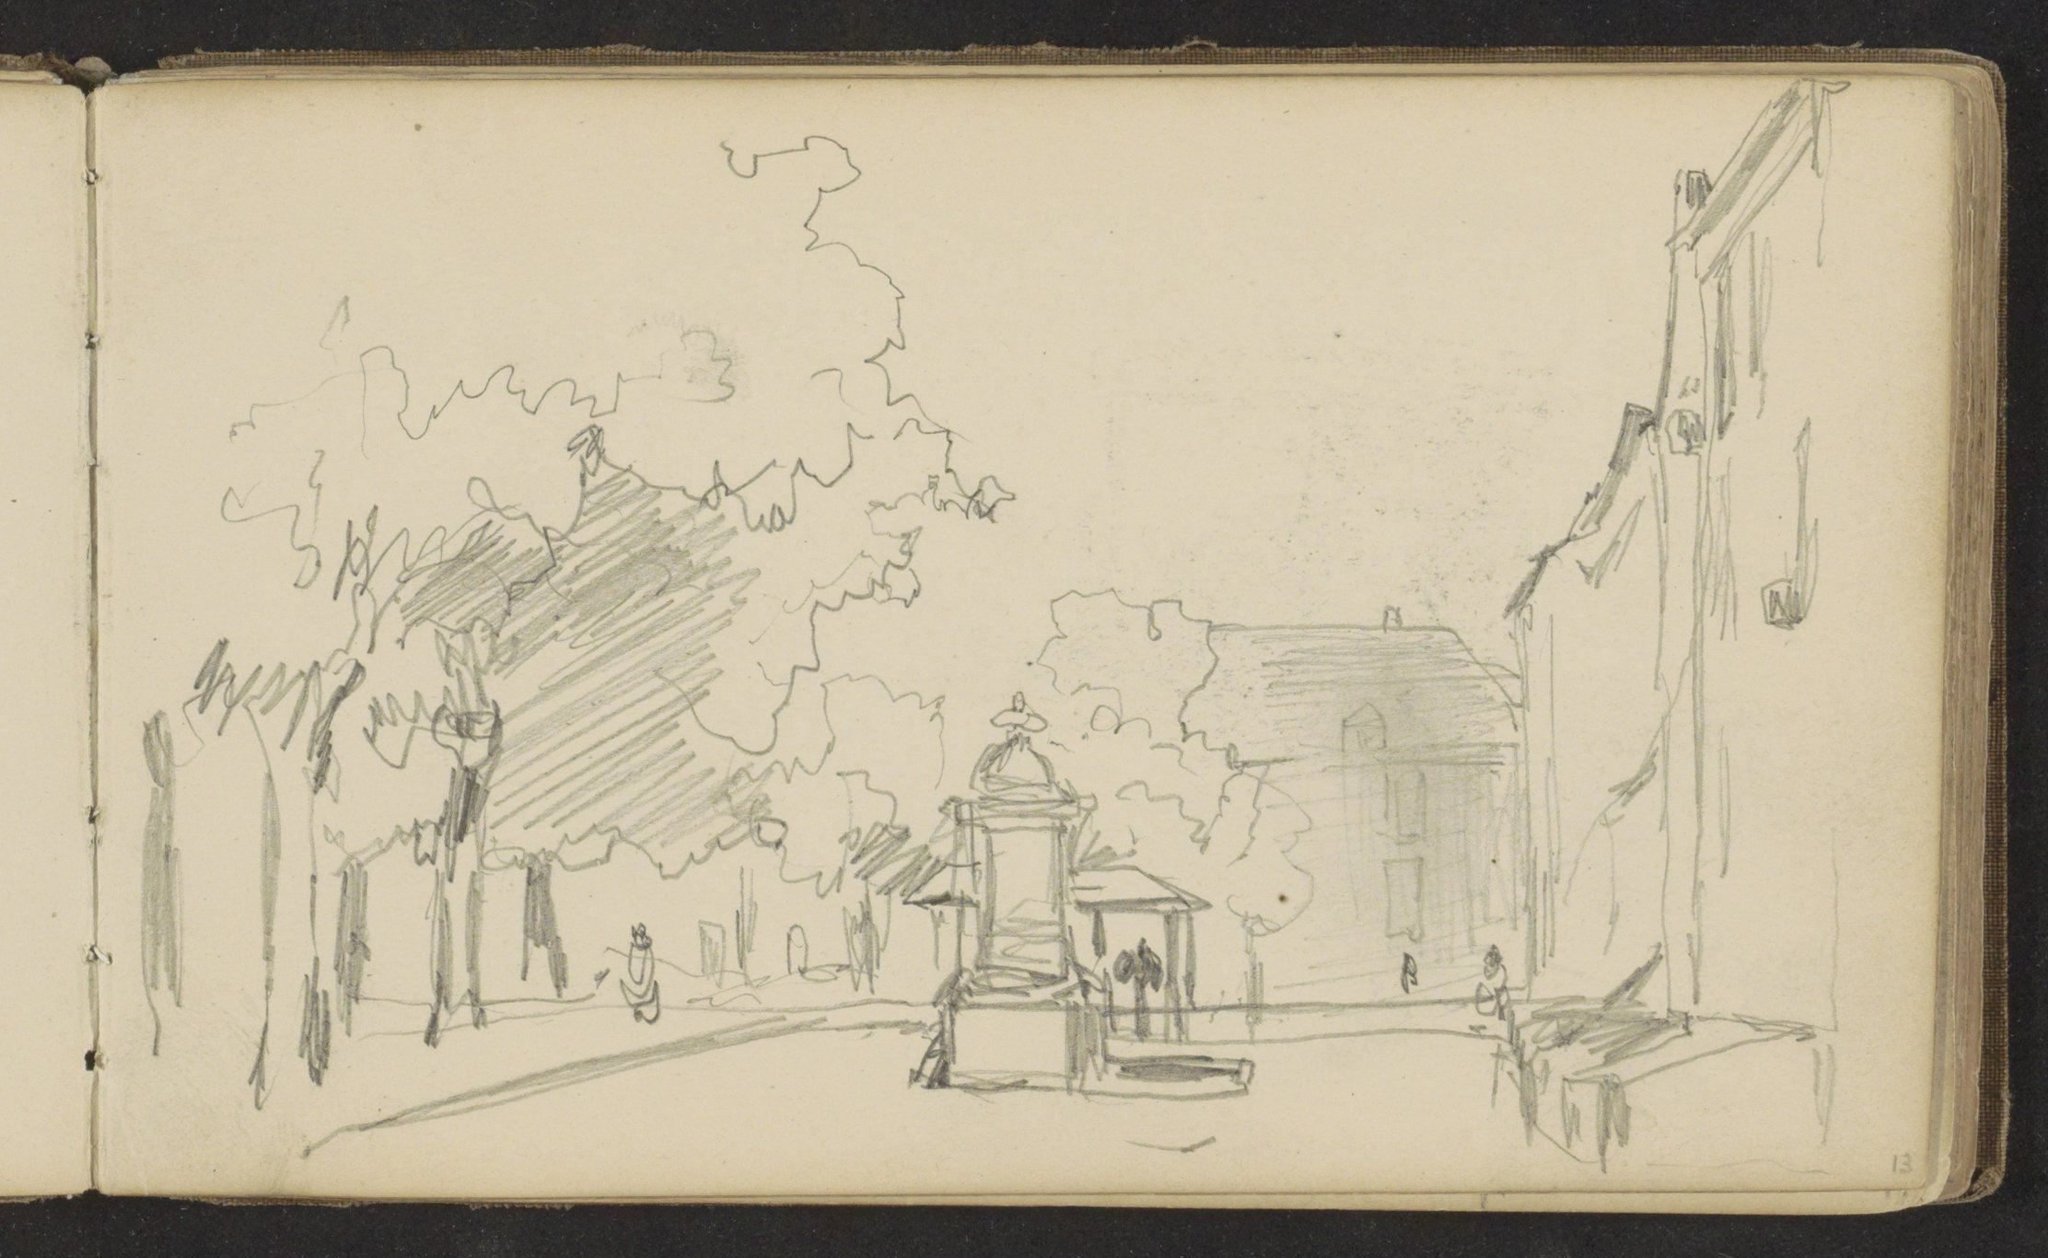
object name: sketchbook leaf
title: Stadsplein met figuren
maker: johan hendrik weissenbruch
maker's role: draughtsman, painter, print maker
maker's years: 1824-1903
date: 1834-1903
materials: paper, pencil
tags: square, place, circus, etc., street (+ city(-scape) with figures, staffage)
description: Op het stadsplein staat een waterput of fontein. Blad 13 recto uit een schetsboek met 43 bladen.